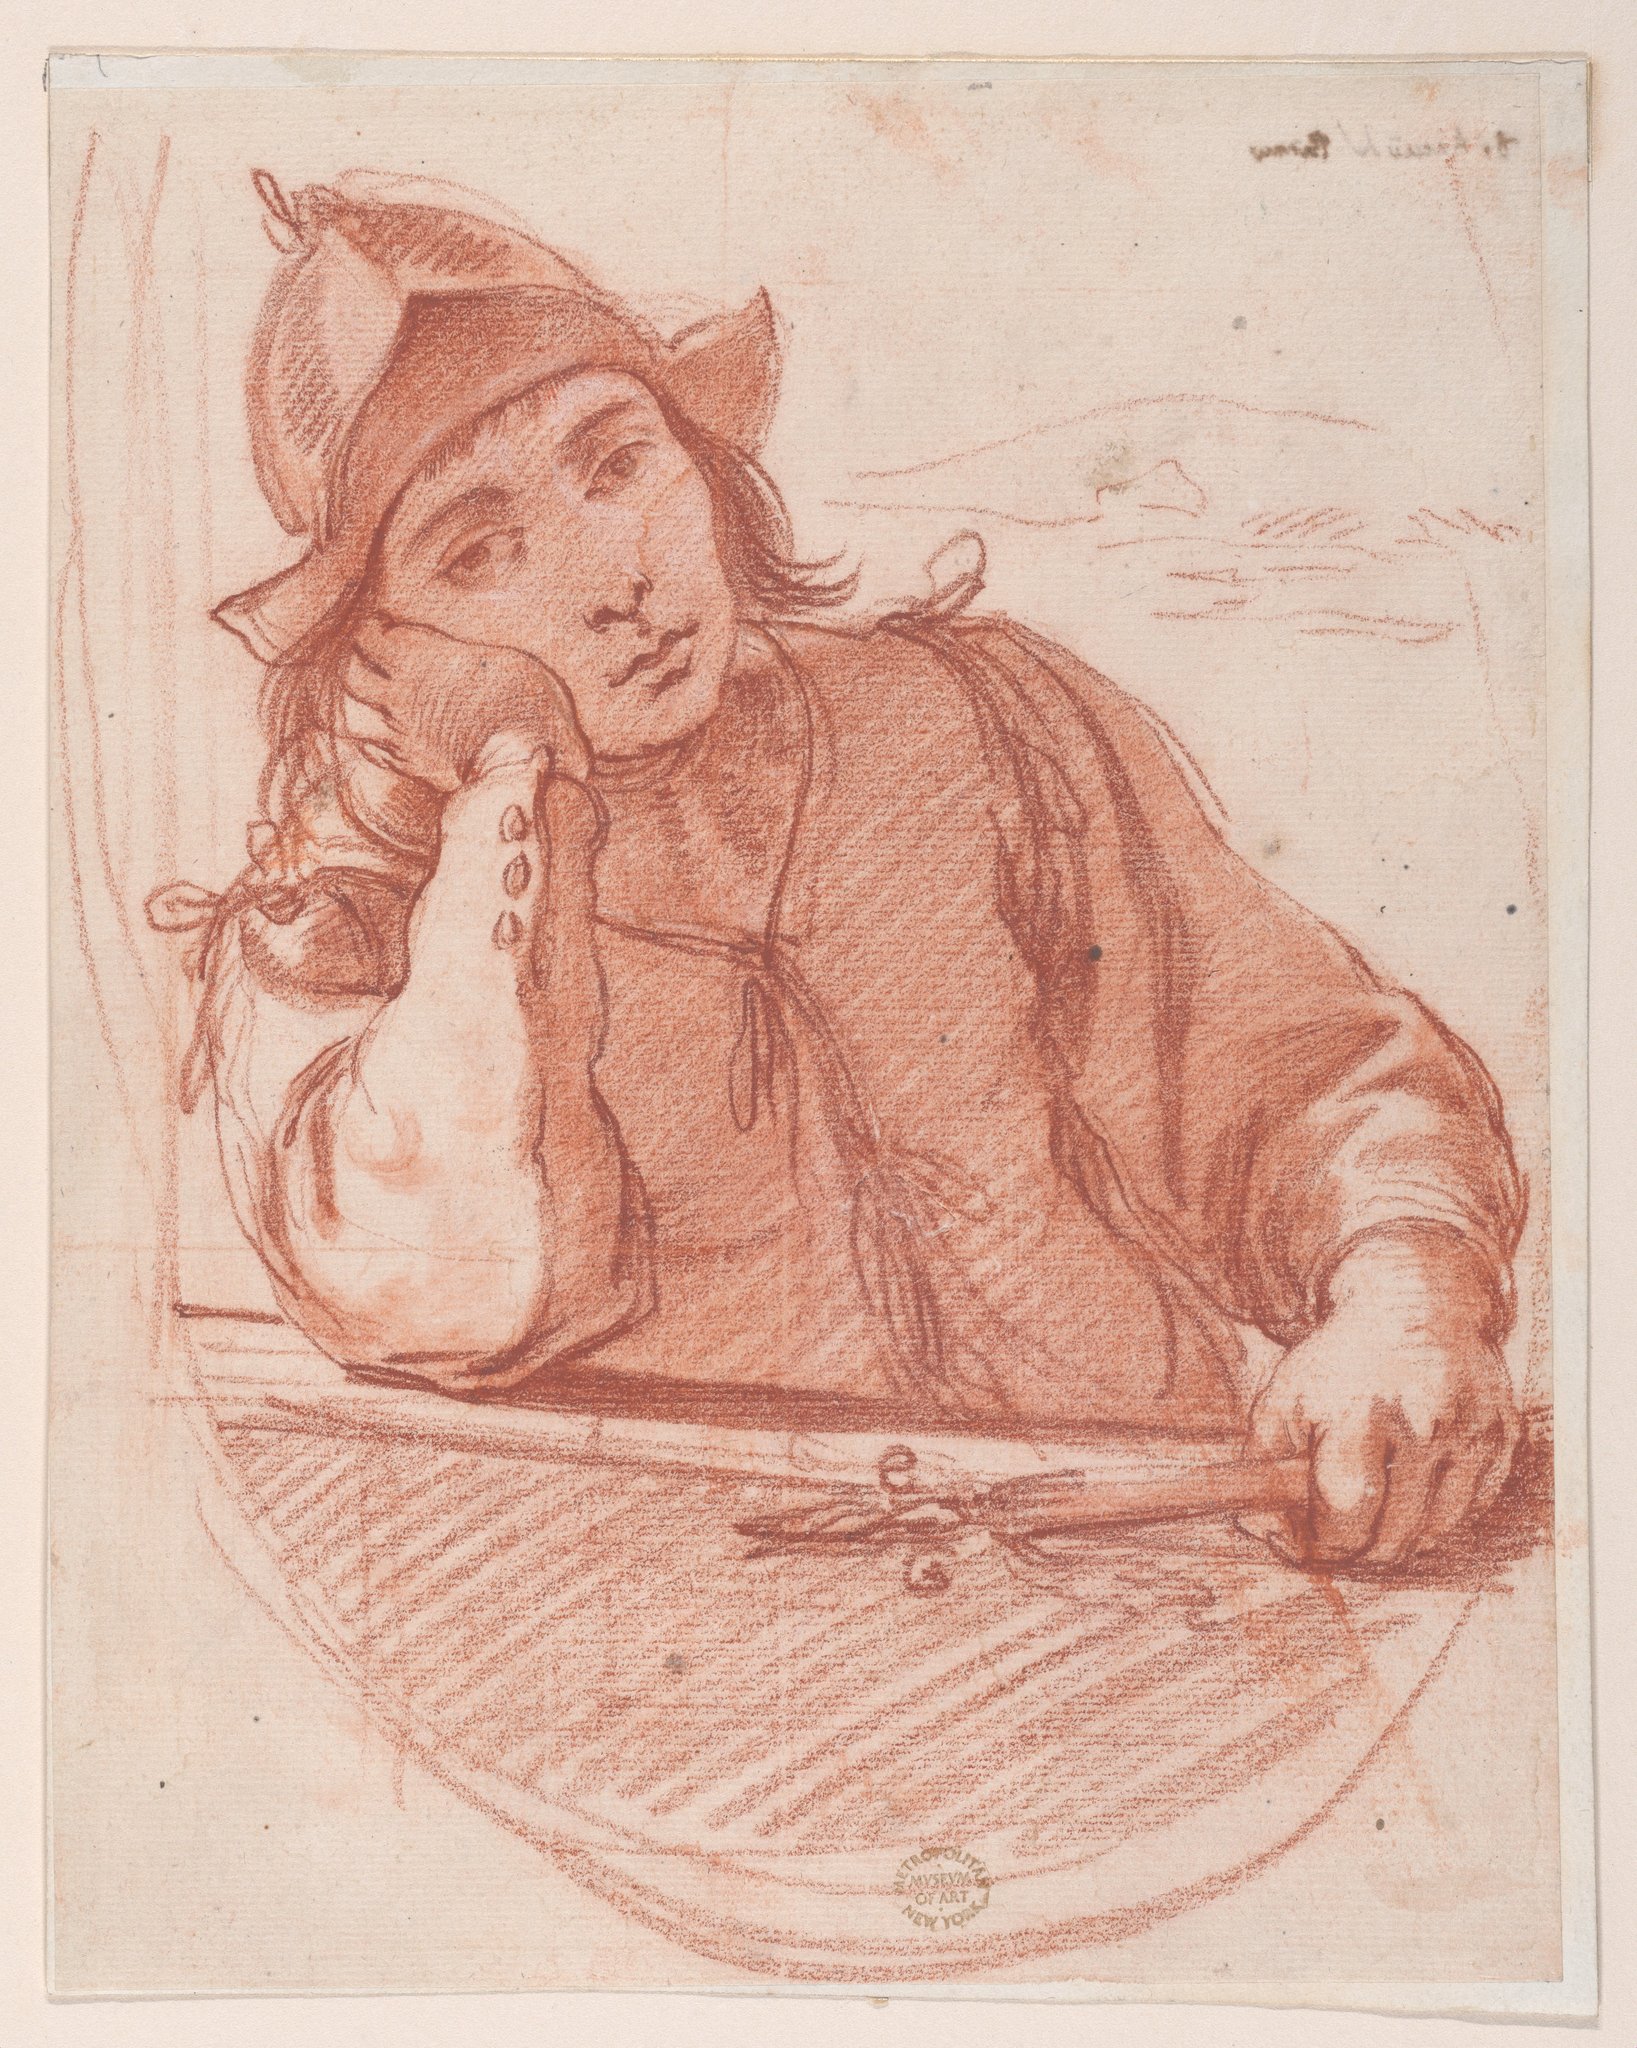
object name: drawing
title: Soldier Resting his Head on his Elbow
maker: giuseppe maria crespi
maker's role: artist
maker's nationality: italian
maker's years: 1665-1747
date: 1701-1800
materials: chalk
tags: soldiers,men